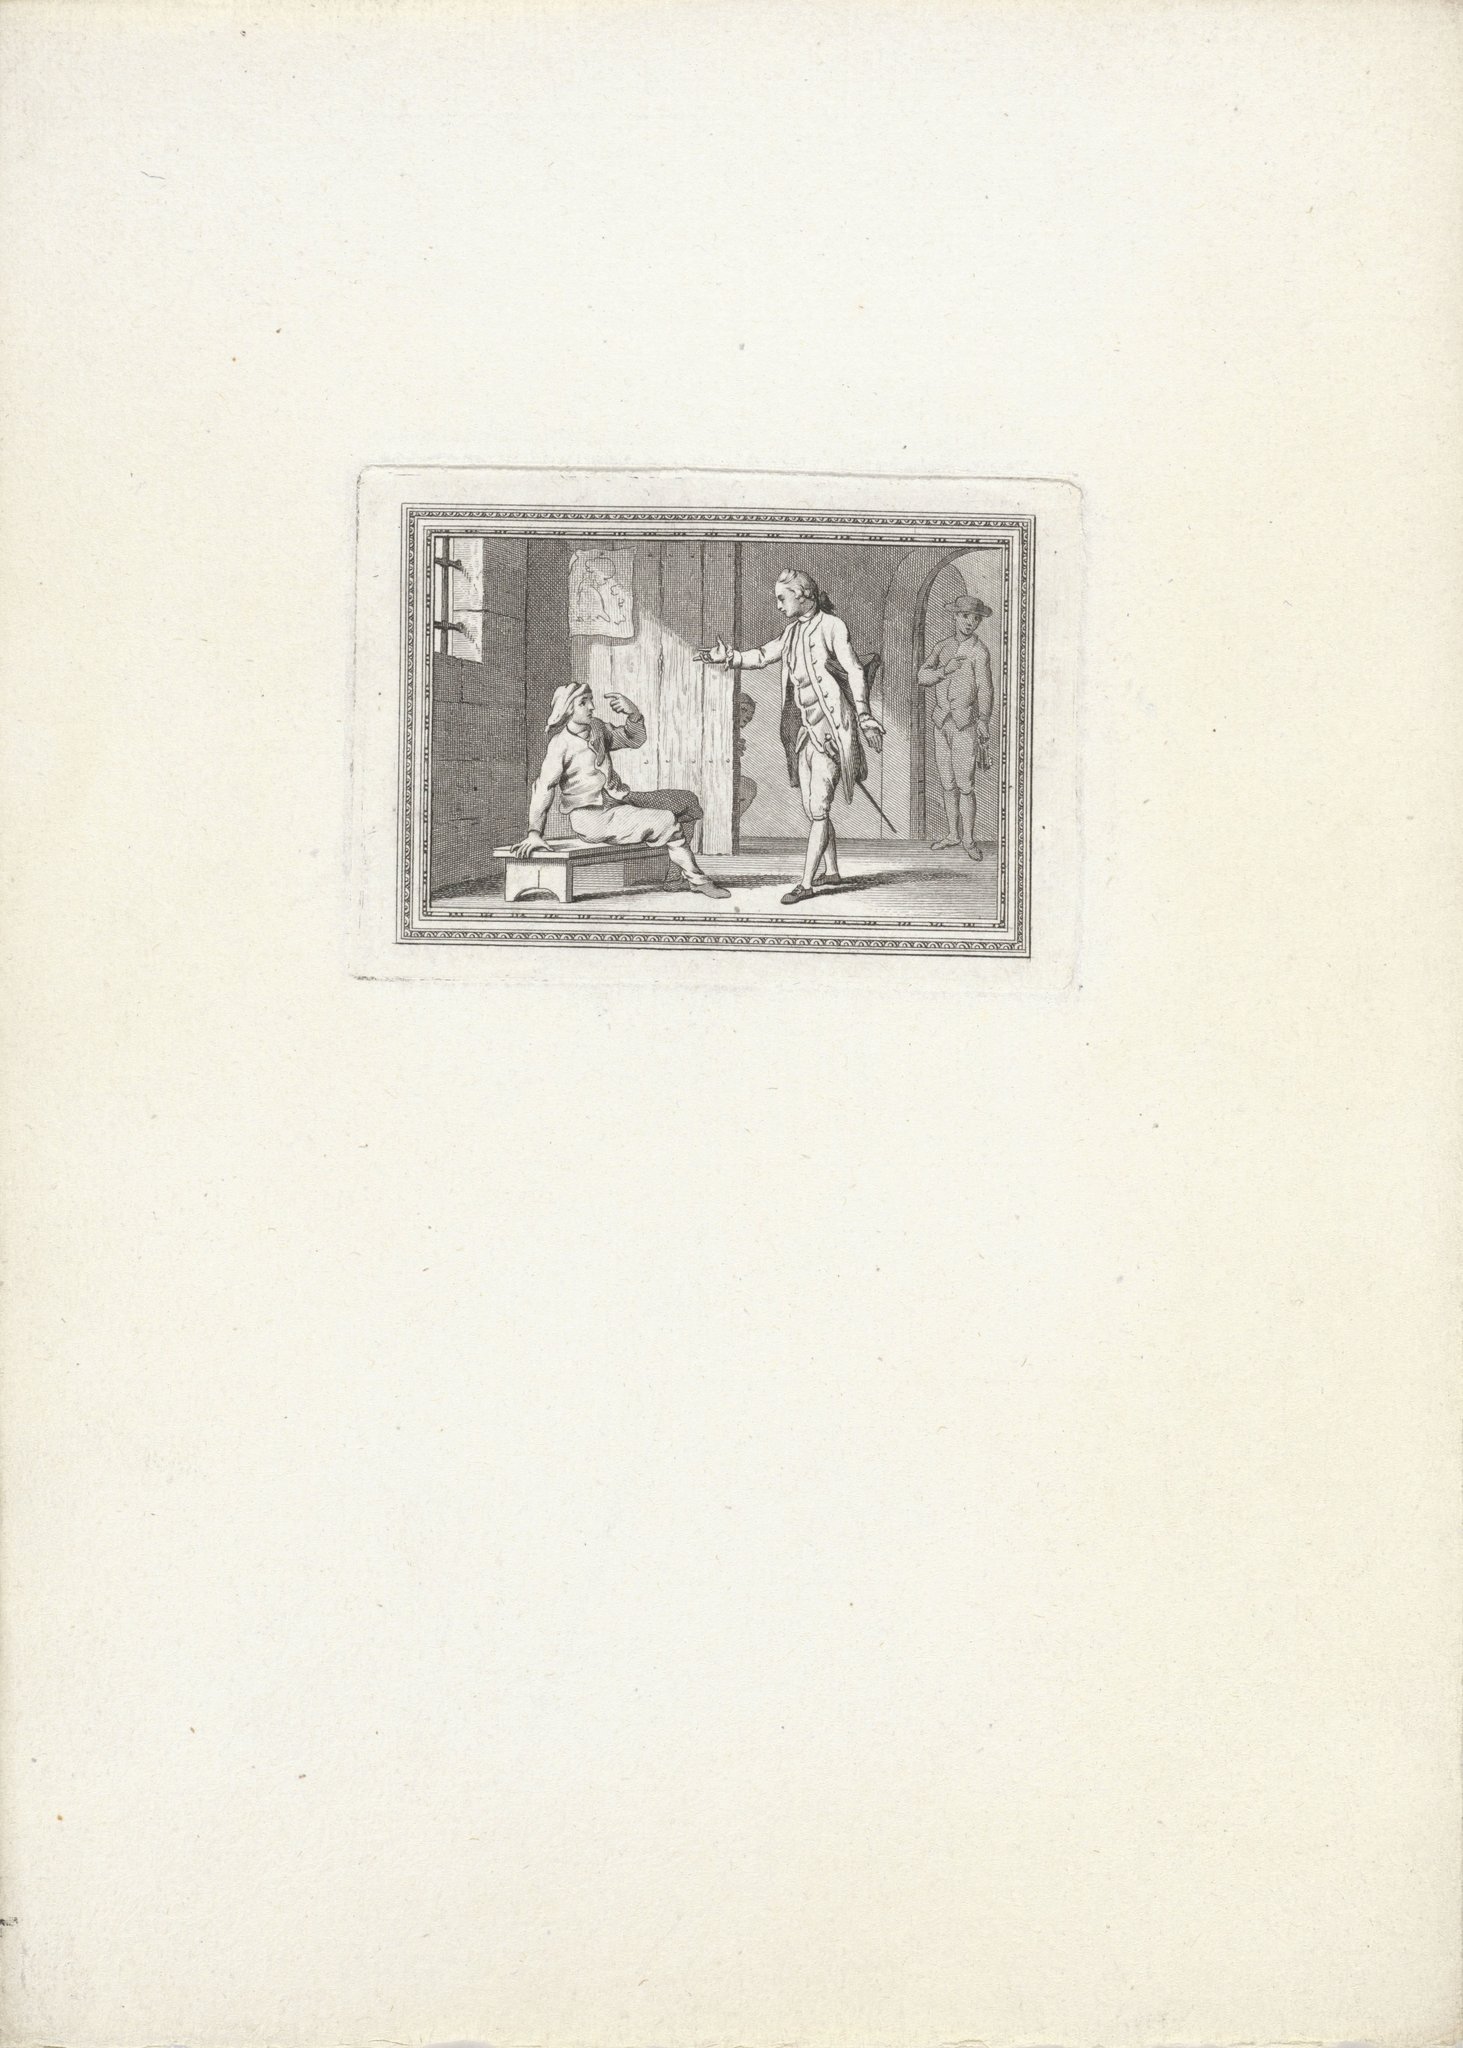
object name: book illustration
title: De vapeurs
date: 1792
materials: paper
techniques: etching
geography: amsterdam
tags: lunatic asylum, mental home, conversation, dialogue; conversation piece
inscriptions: collector's mark: Lugt 2228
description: Een welgestelde man, die last heeft van opvliegers, is in gesprek met een man in het dolhuis. Illustratie bij het verhaal 'De vapeurs' uit 'Fabelen voor de Nederlandsche jeugd'.